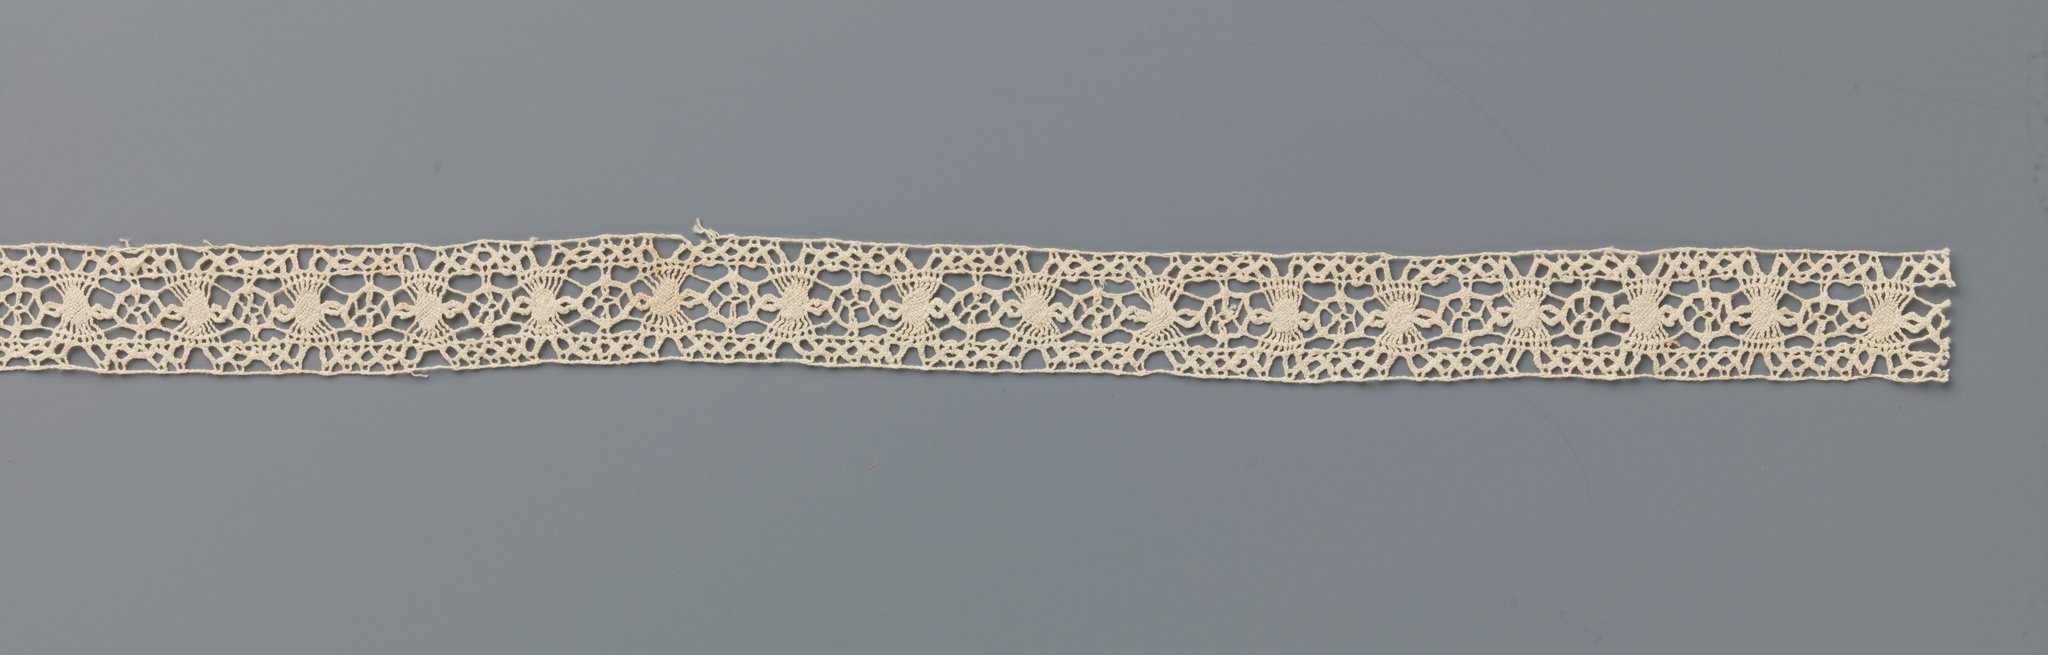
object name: strip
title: Tussenzetsel van kloskant met wieltjes en zonnetjes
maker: Anonymous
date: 1600-1649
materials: linen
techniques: lace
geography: italy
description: Tussenzetsel van naturelkleurig kloskant. Het is mogelijk bedoeld om te gebruiken als sierrand in een laken. Het patroon bestaat uit twee smalle banen met daartussen een bredere baan met een zich herhalend motief van een wieltje, die links en rechts wordt geflankeerd door een zonnetje. In de smalle banen, staan rijtjes van vijf ruitjes gemaakt met vlechtjes over het motief heen, steeds met een onderbreking naar het volgende motief. Boven- en onderzijde van de strook zijn recht afgewerkt.